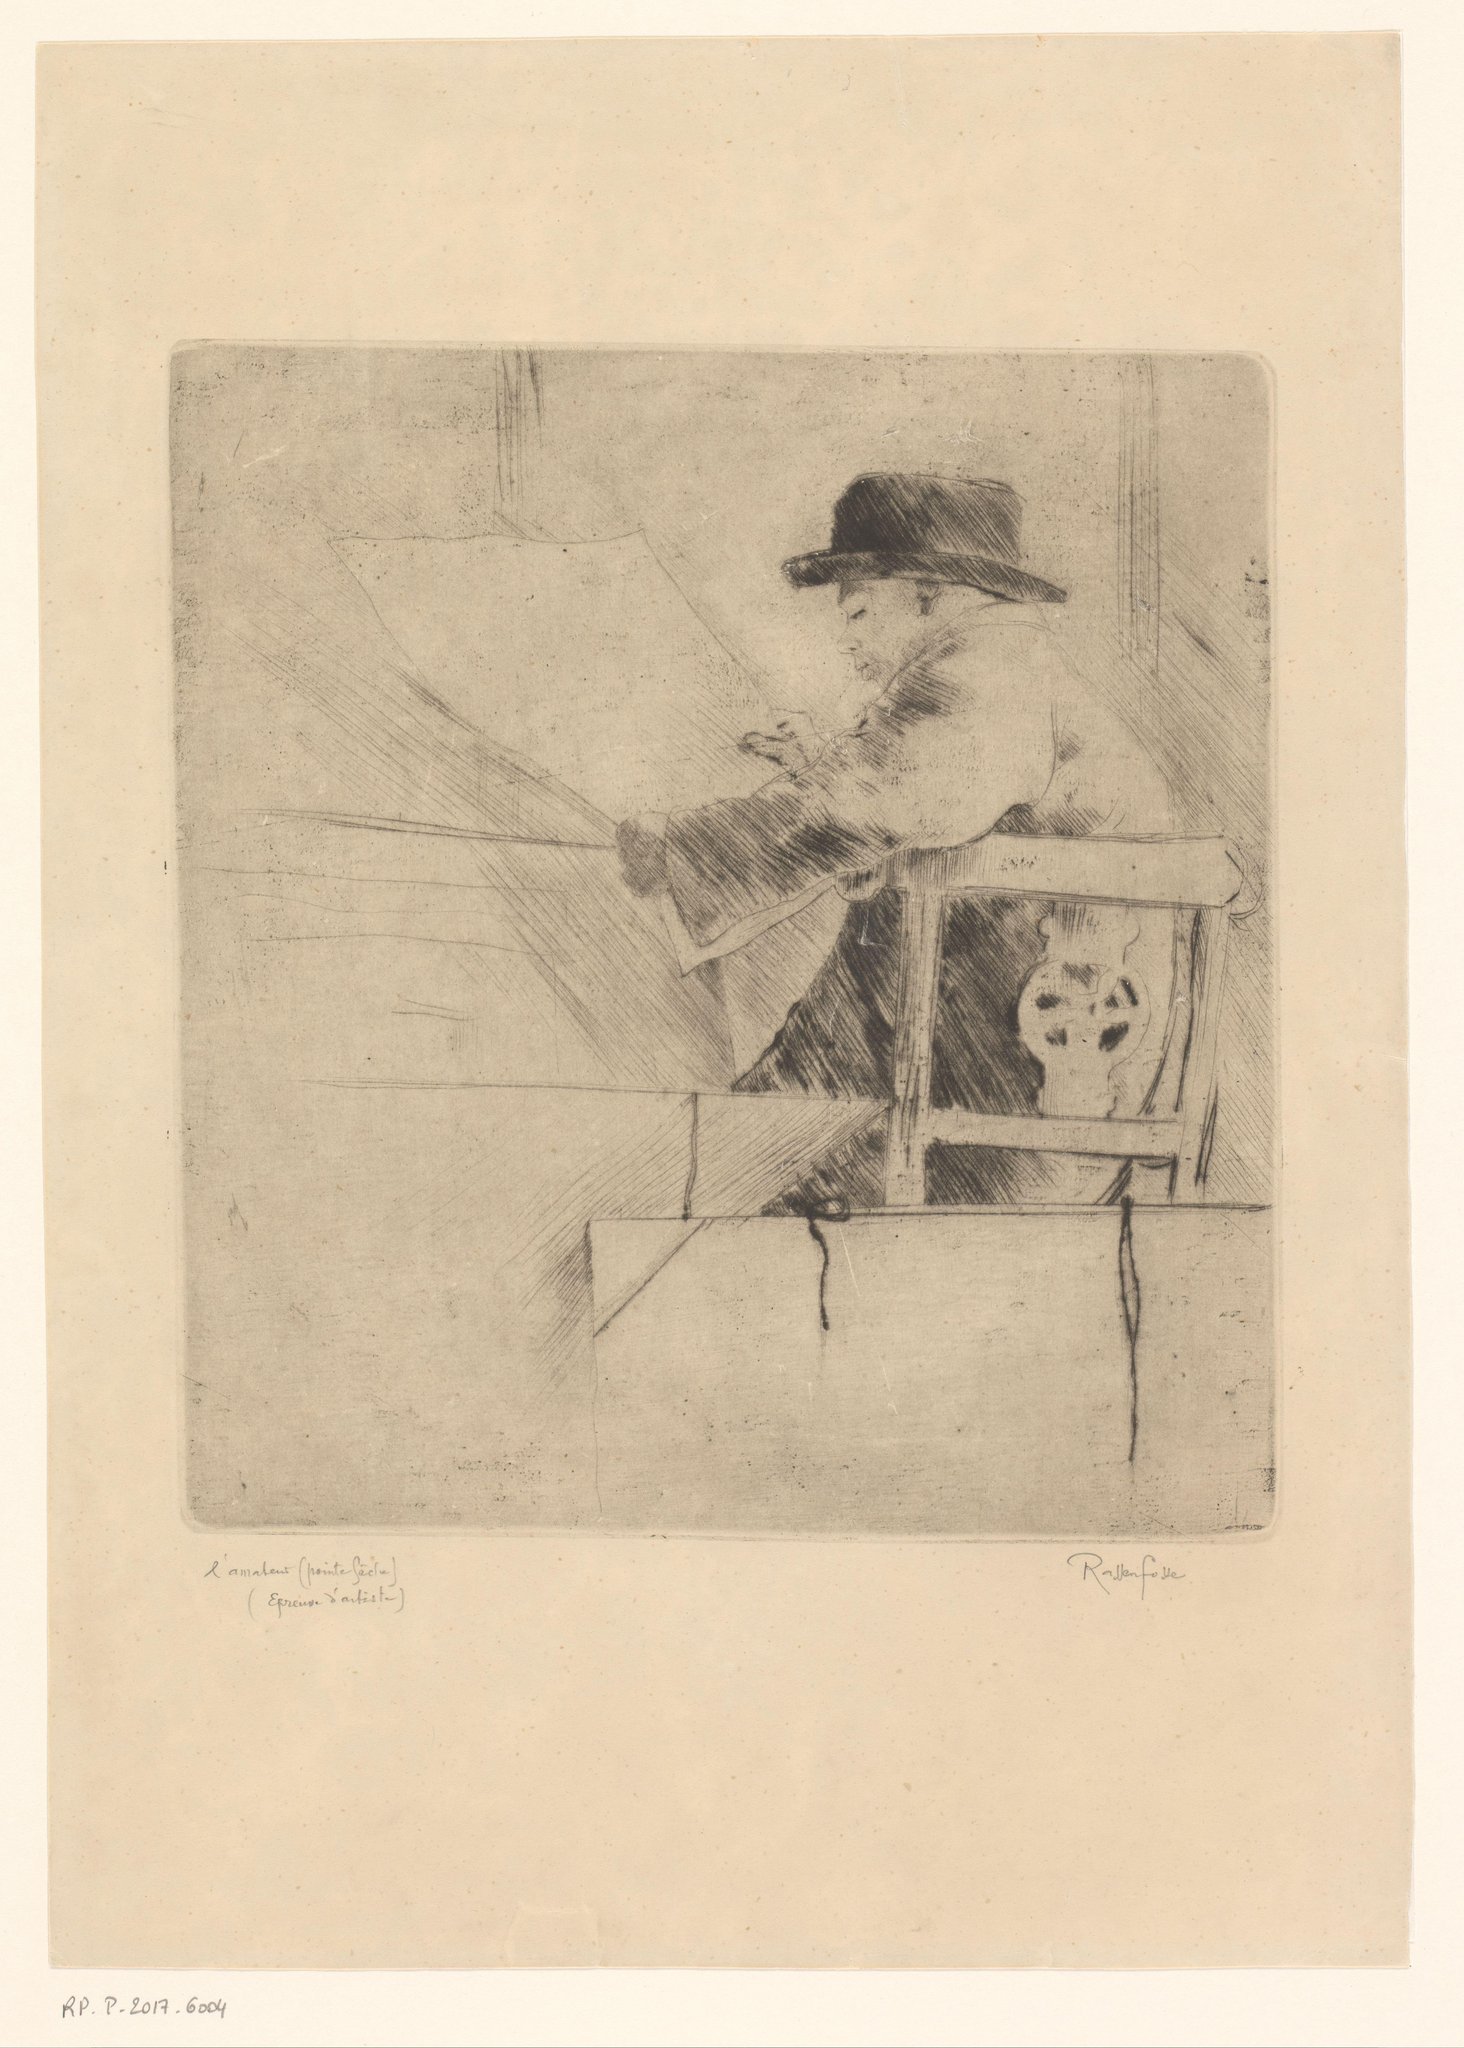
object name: print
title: De prentliefhebber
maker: armand rassenfosse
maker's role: draughtsman, painter, print maker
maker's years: 1862-1934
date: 1924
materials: paper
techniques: drypoint, intaglio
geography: liège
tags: art trade, art shop, print, e.g.: engraving, etching, lithograph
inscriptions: collector's mark: Lugt 2760, collector's mark: Lugt 2228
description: Man met hoed, zittend op een stoel, bekijkt een prent. Tegen de stoel staat een map met loshangende touwtjes geleund.